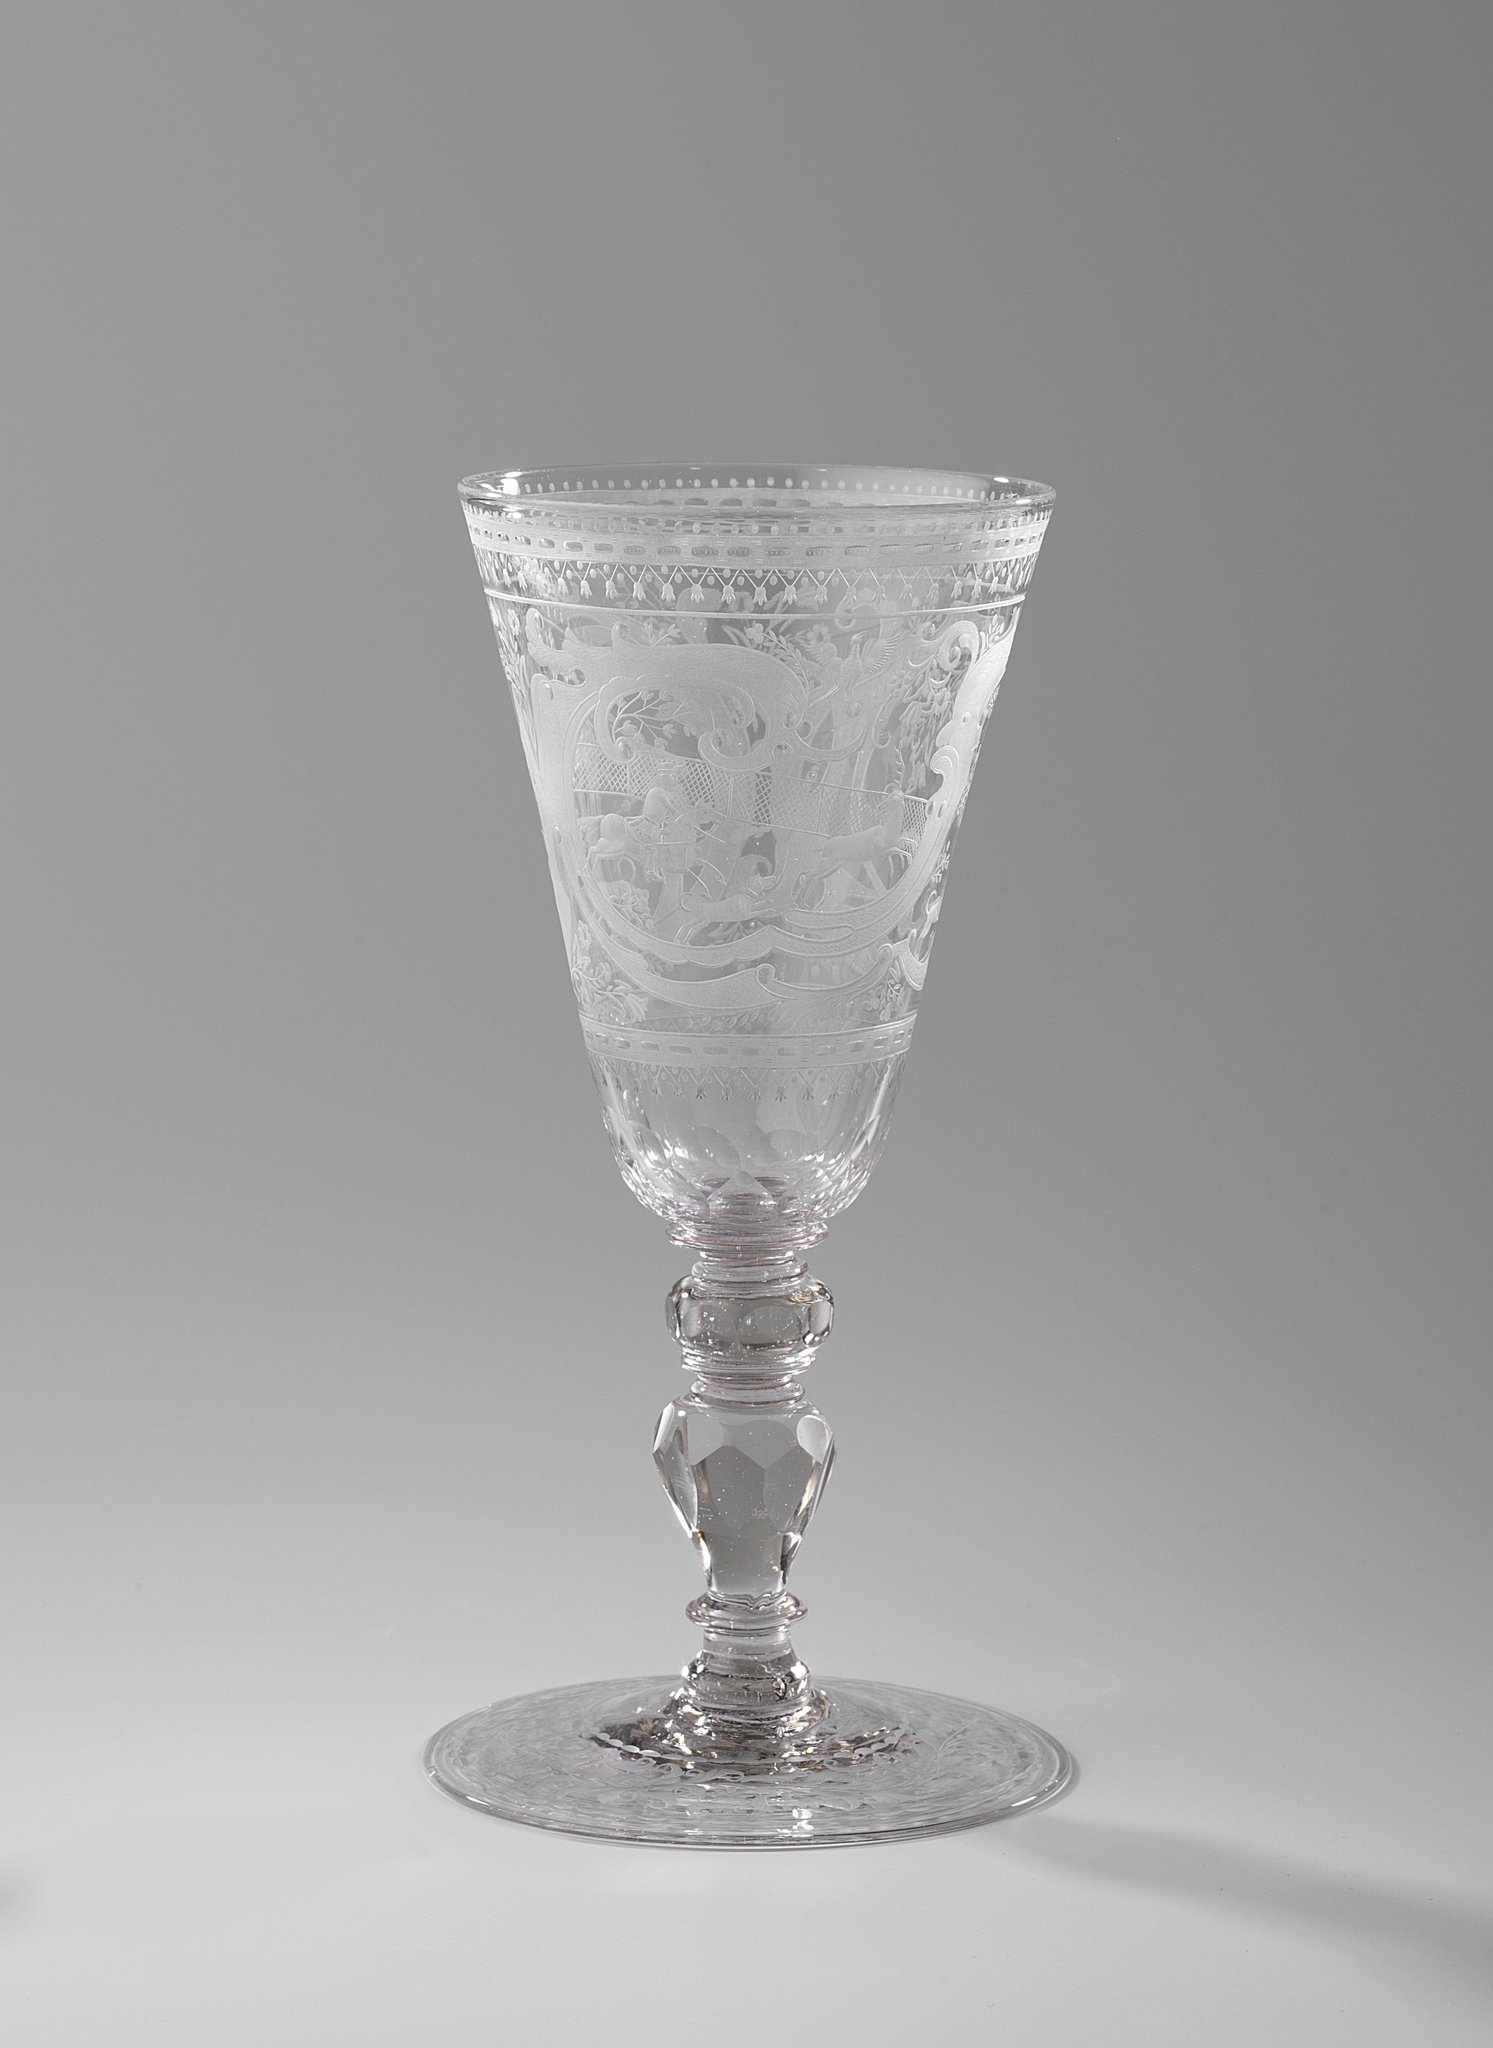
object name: goblet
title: Wine glass with a scene of a hunting party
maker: Anonymous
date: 1725-1750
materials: glass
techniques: glassblowing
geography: germany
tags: hunting, chase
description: Kelkglas. Radgravure met een hertenjacht. Duitsland, ca. 1725 - 1750. Legaat mr. A.J. Enschedé, 1896.